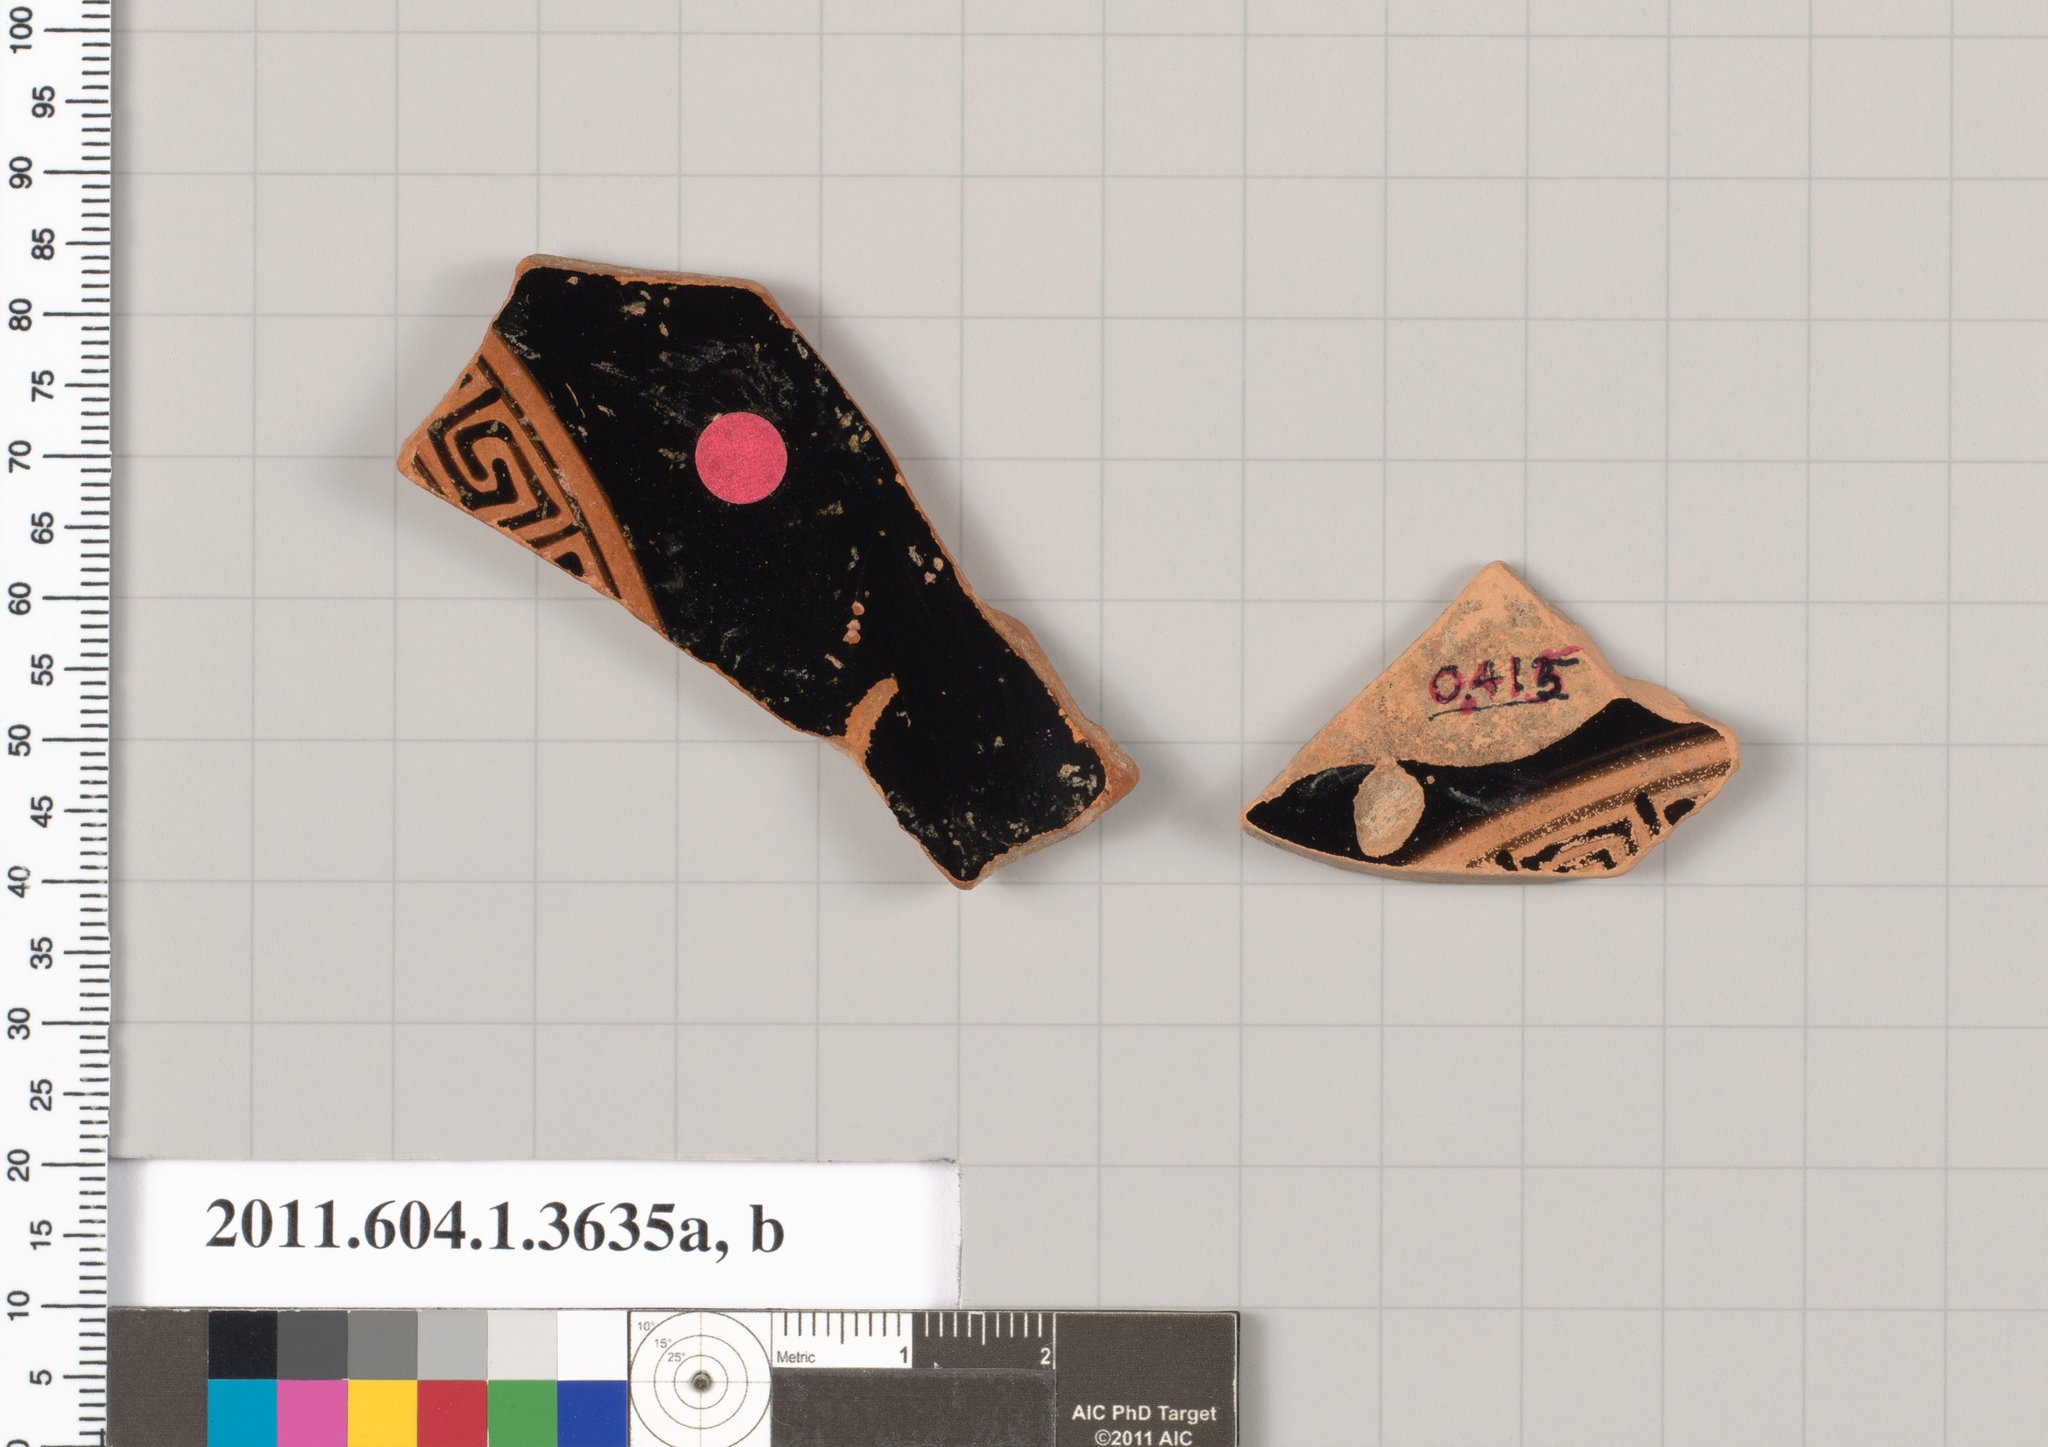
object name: kylix fragment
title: Terracotta fragments of kylikes (drinking cups)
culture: greek, attic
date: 500-470 BCE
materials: terracotta